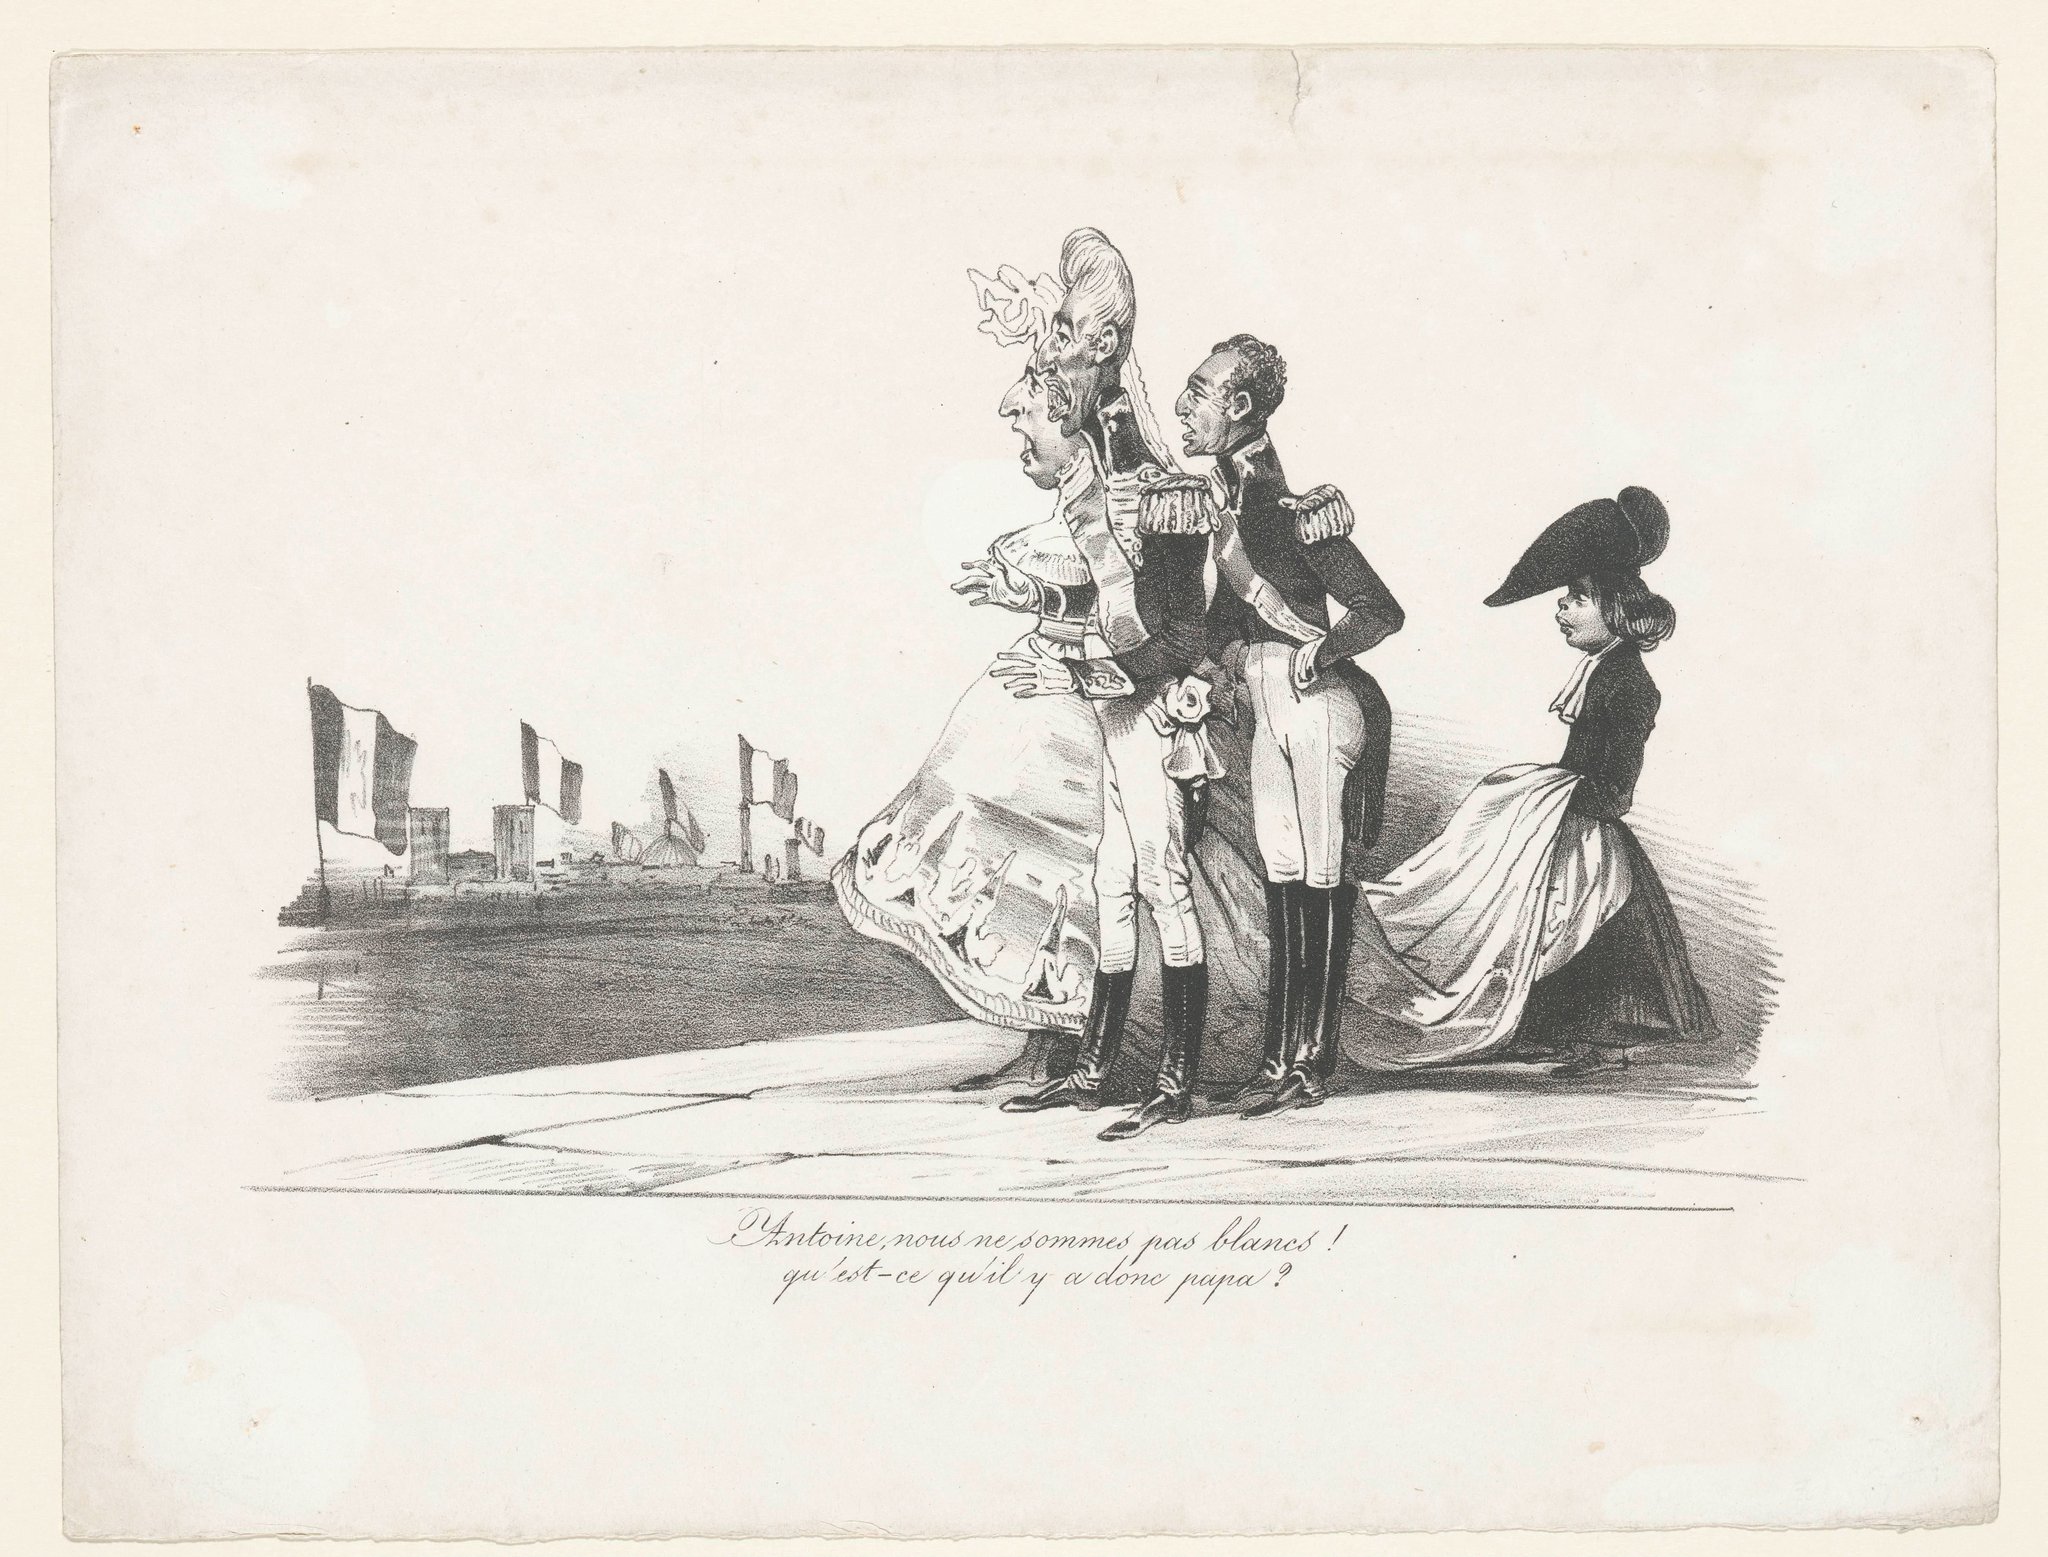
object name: cartoon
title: Karel X en de Julirevolutie, 1830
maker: Anonymous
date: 1830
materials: paper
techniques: lithograph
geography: france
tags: marie thérèse charlotte van frankrijk, political demonstration, the old government and its supporters (after revolution), revolution, revolt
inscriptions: collector's mark: Lugt 2228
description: Spotprent op koning Karel X tijdens de Julirevolutie, 27-29 juli 1830. Karel X kijkt met zijn zoon Lodewijk Anton van Bourbon en diens vrouw Marie Thérèse Charlotte, naar een optocht waarin de Franse driekleur wordt gevoerd. Met tweeregelig Frans onderschrift.